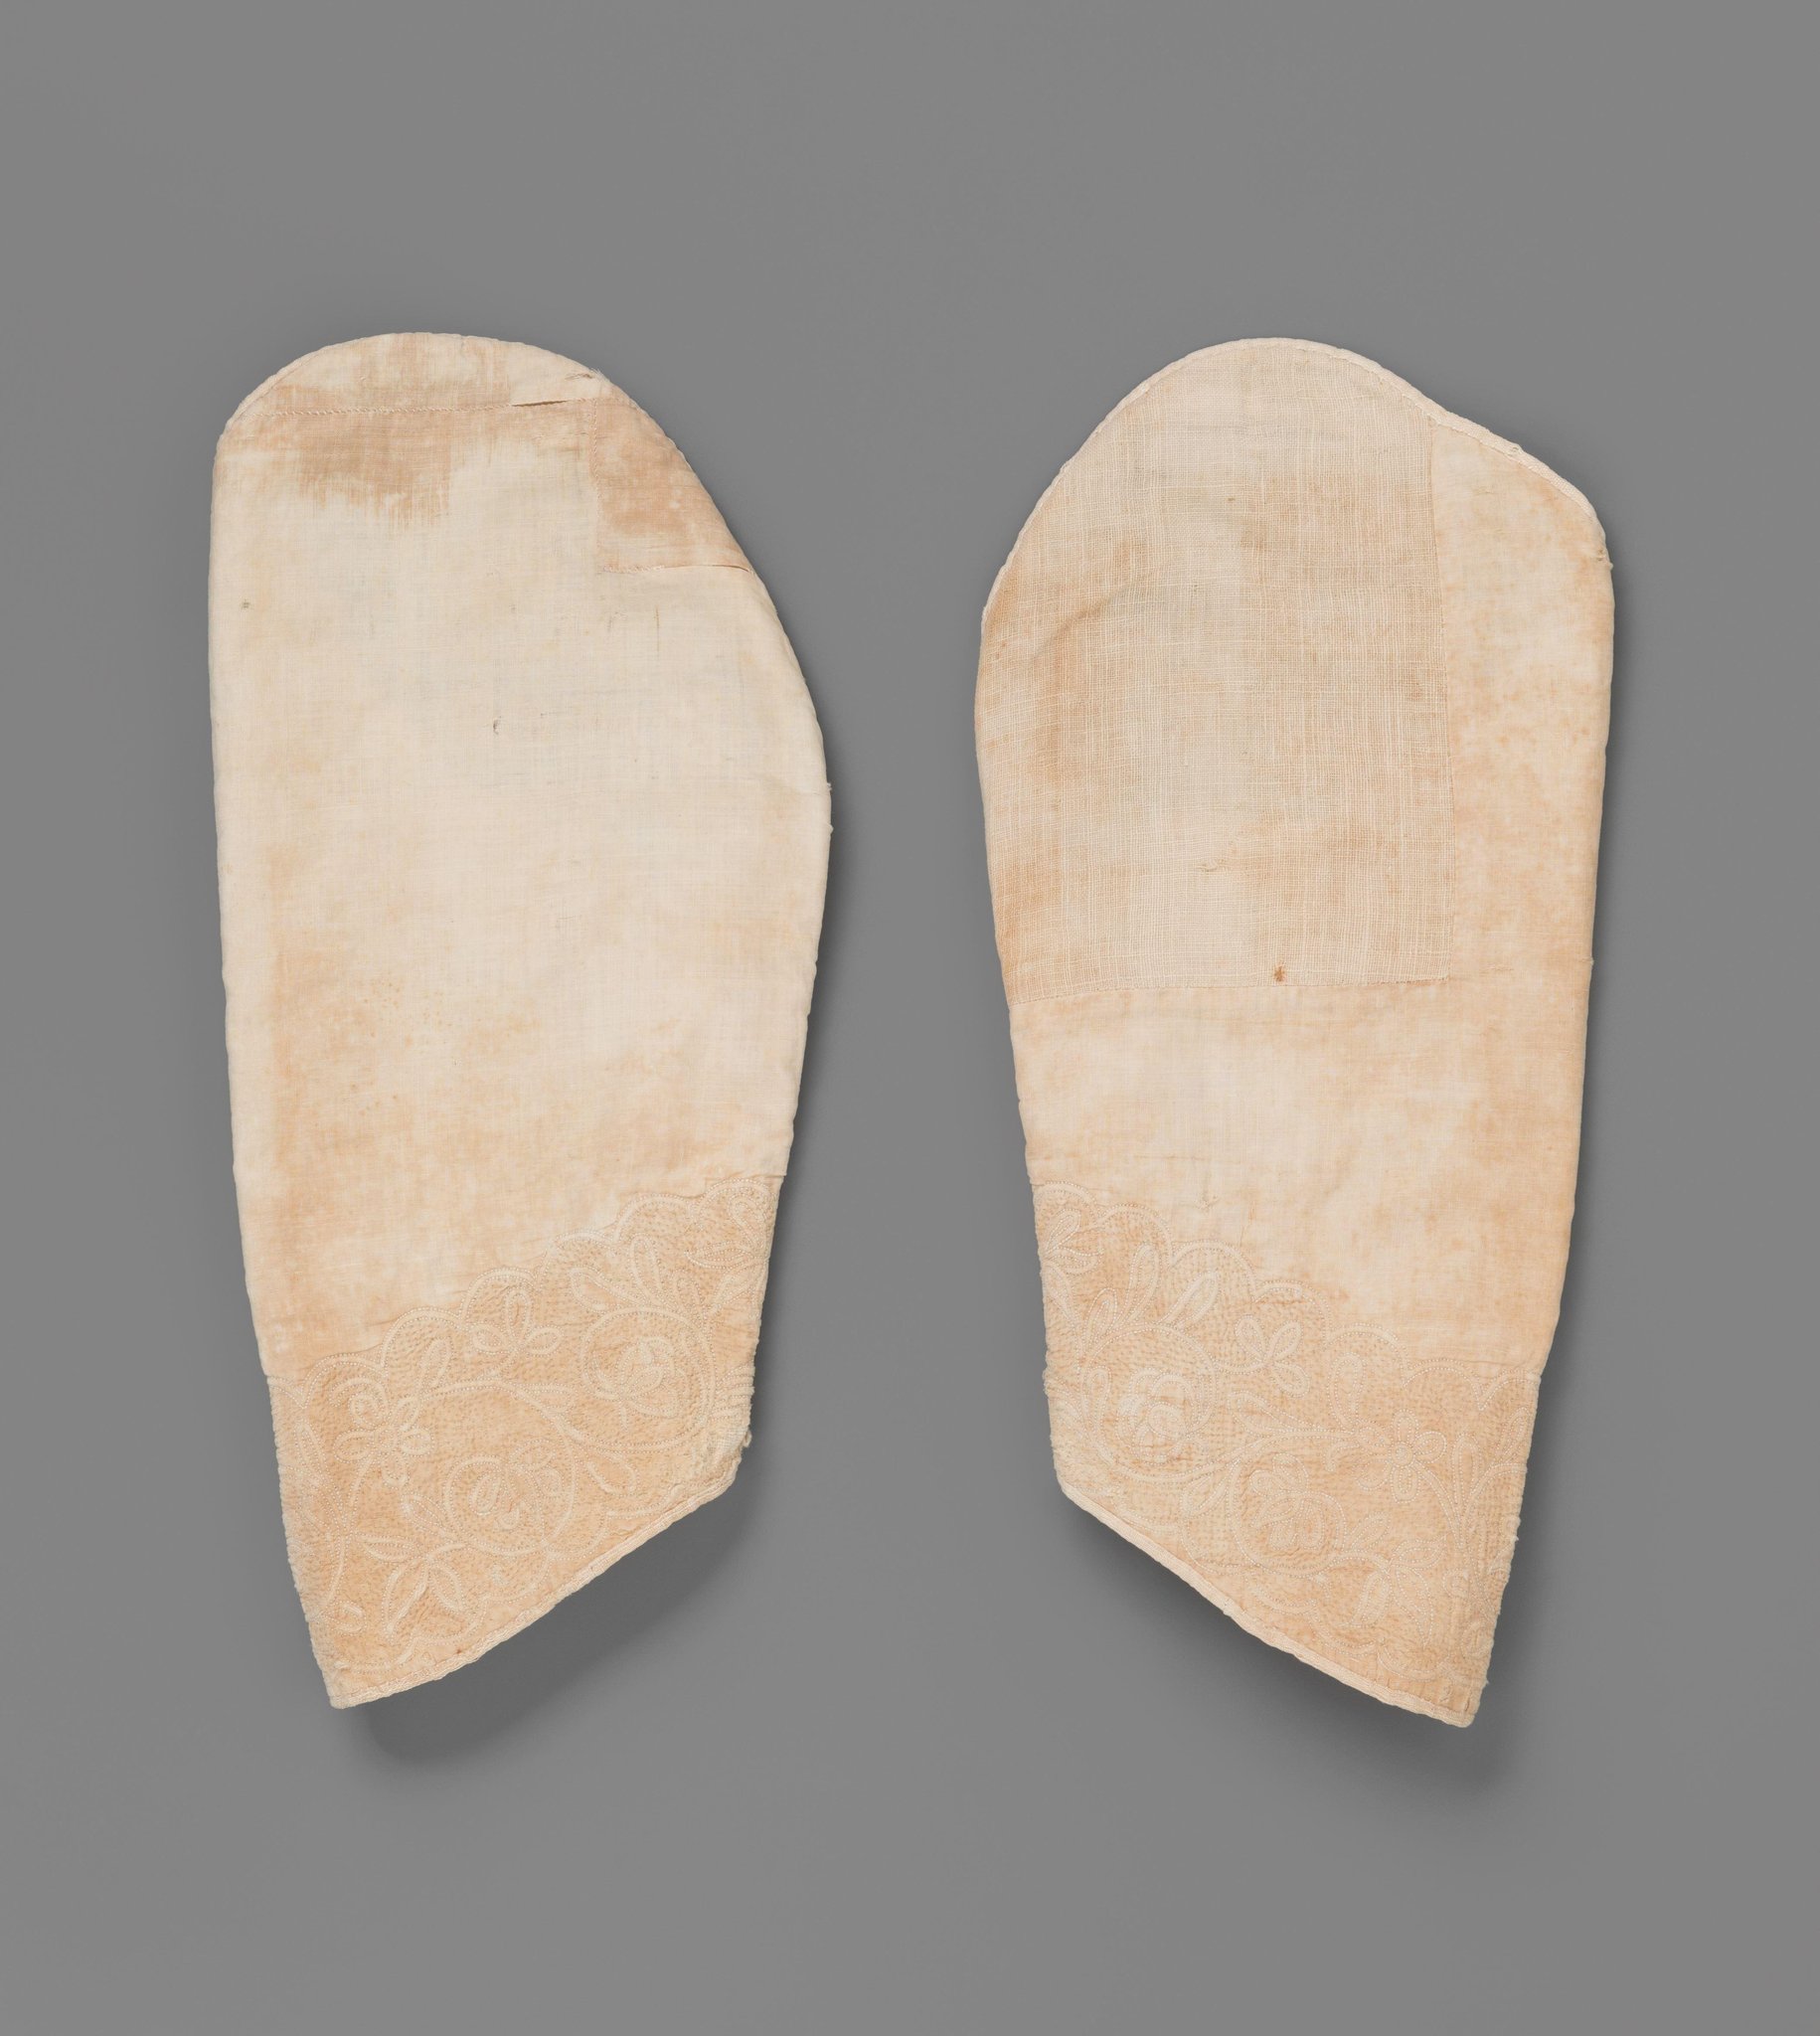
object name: womenswear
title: Ondermouw met bloemenranken in point de Marseille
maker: Anonymous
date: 1750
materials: textile, linen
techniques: quilted embroidery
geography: western europe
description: Ondermouw met aan de onderzijde een rand van bloemenranken in point de Marseille.